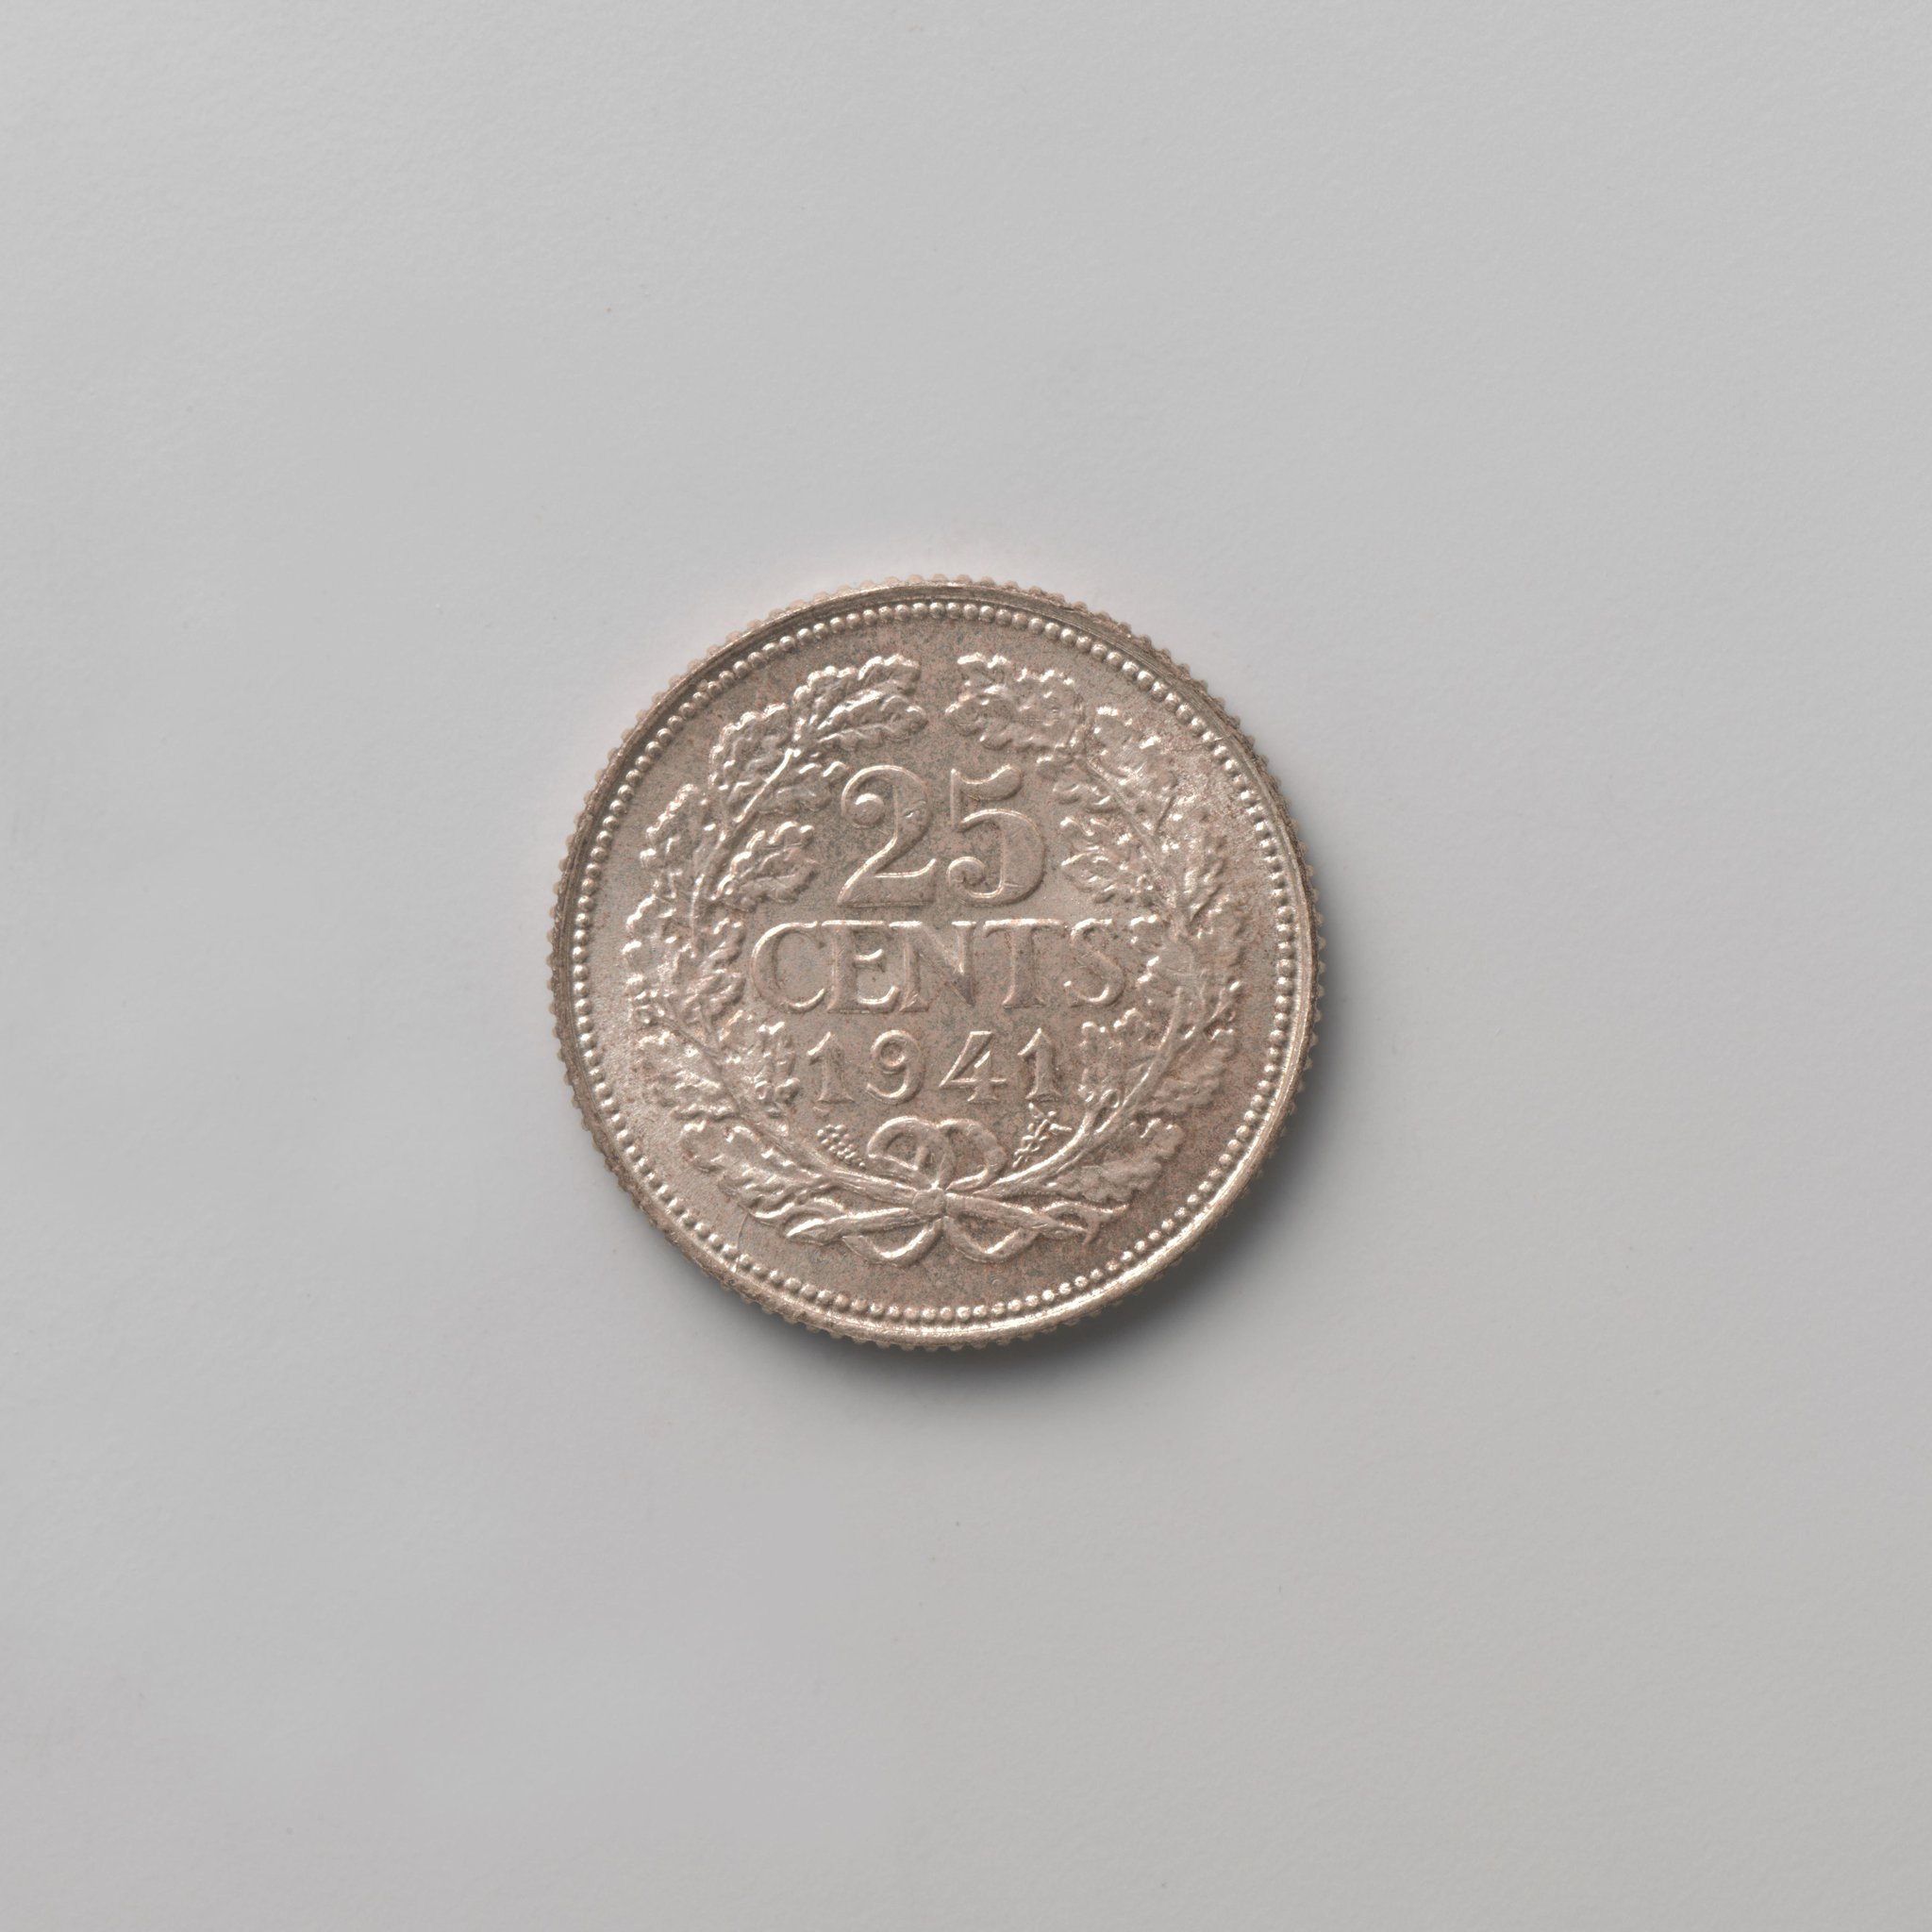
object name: coin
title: Nederland, 25 cent,1941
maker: wilhelmina of the netherlands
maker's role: print maker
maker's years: 1880-1962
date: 1941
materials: silver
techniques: striking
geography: utrecht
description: Zilveren munt. Voorzijde: hoofd naar links. Keerzijde: binnen twee samengebonden eiketakken waarde-aanduiding 25 cents en jaartal. Kartelrand.